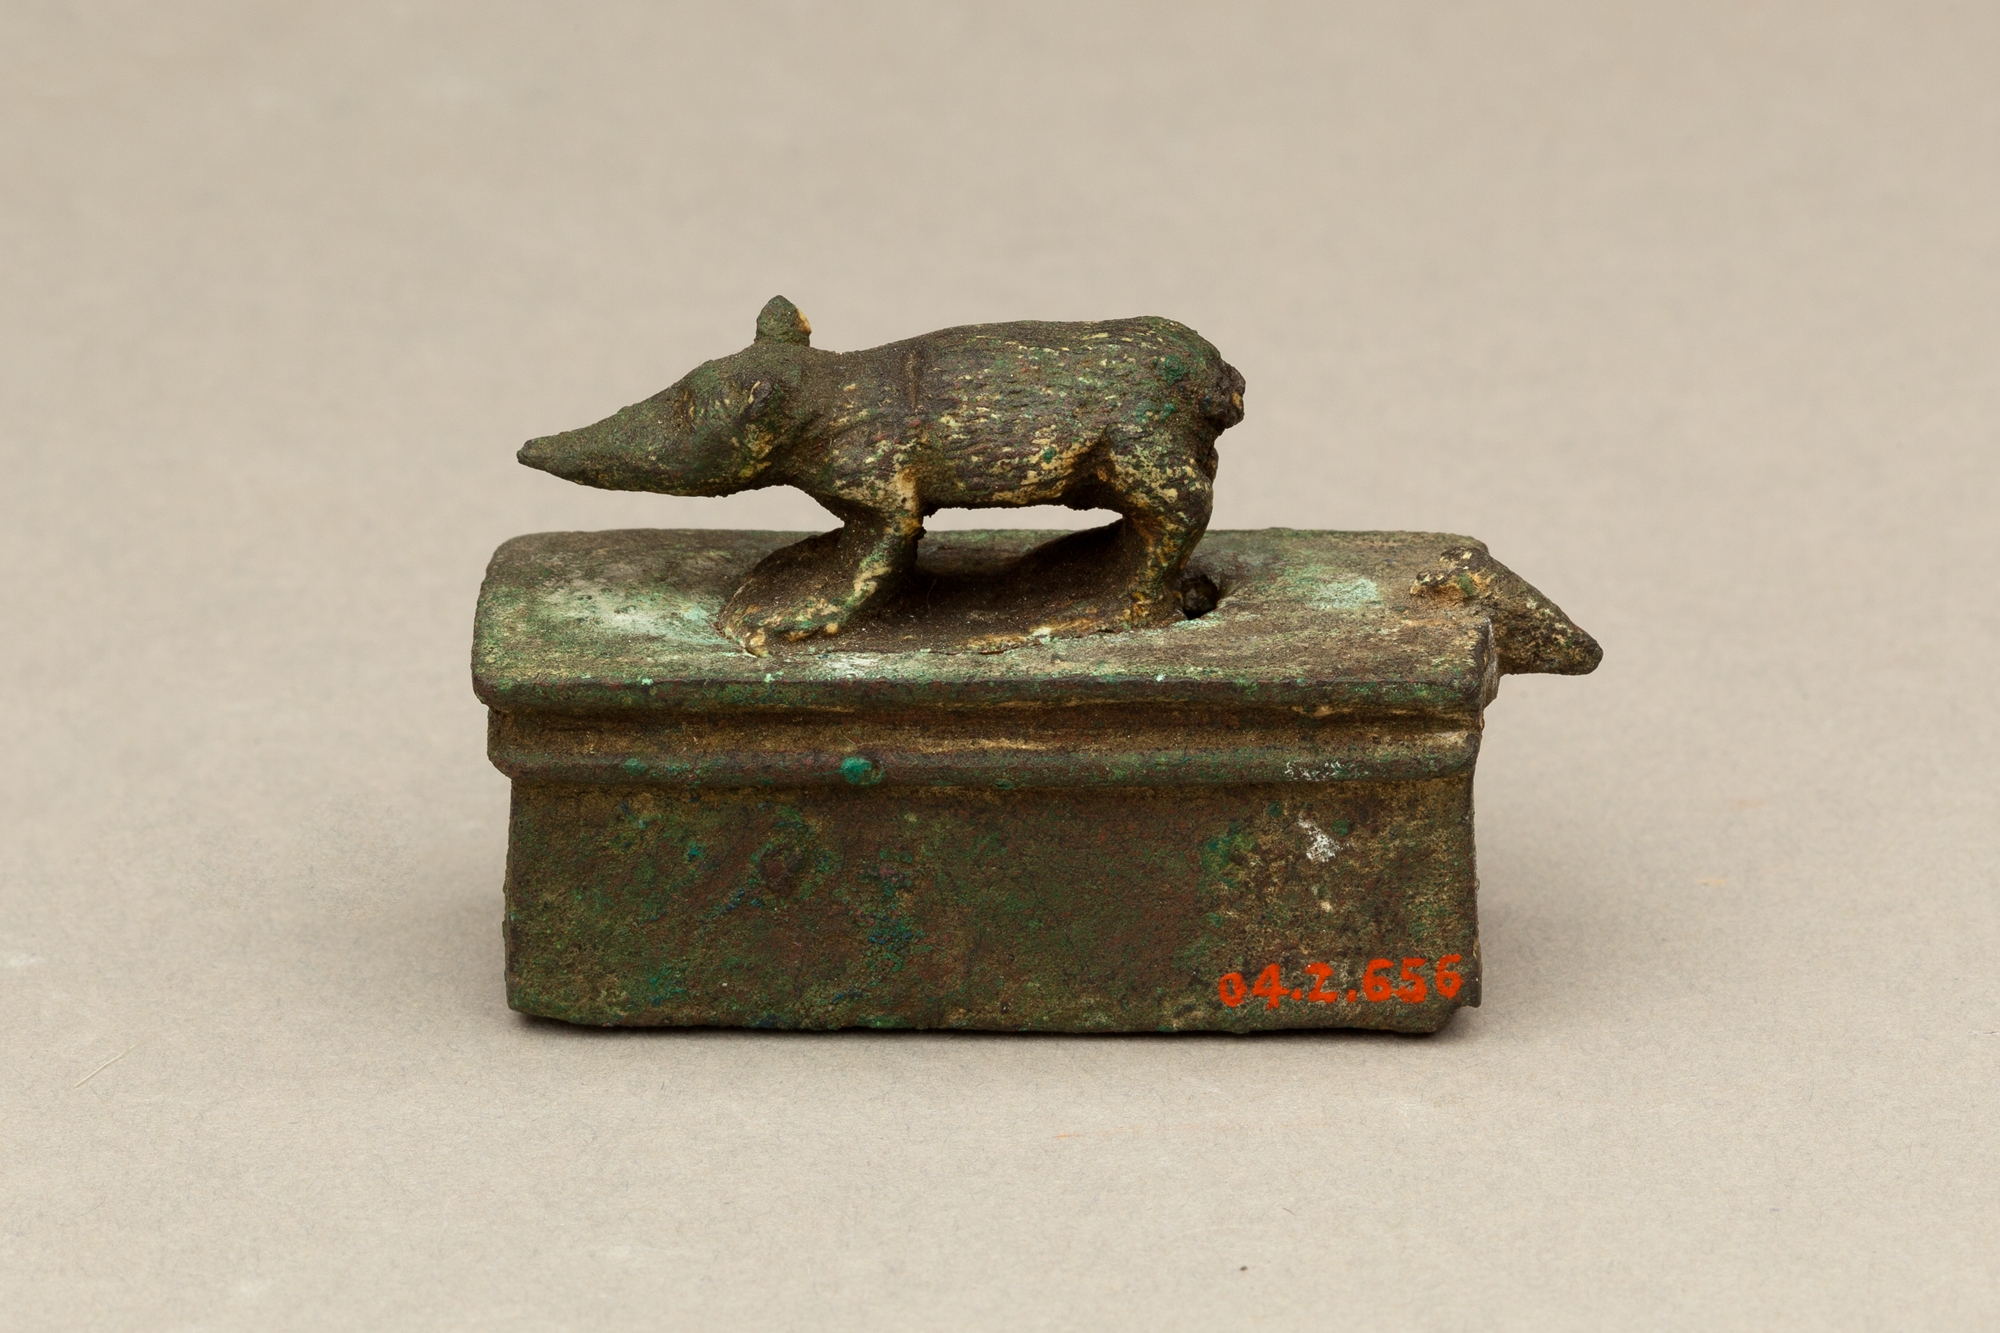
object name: figurine, shrew mouse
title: Shrew-mouse surmounting shrine-shaped box for an animal mummy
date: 664-630 BCE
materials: metal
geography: egypt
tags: mice,sarcophagus